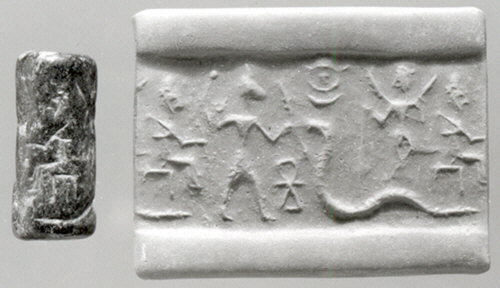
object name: cylinder seal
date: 1800-1601 BCE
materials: stone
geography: syria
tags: snakes